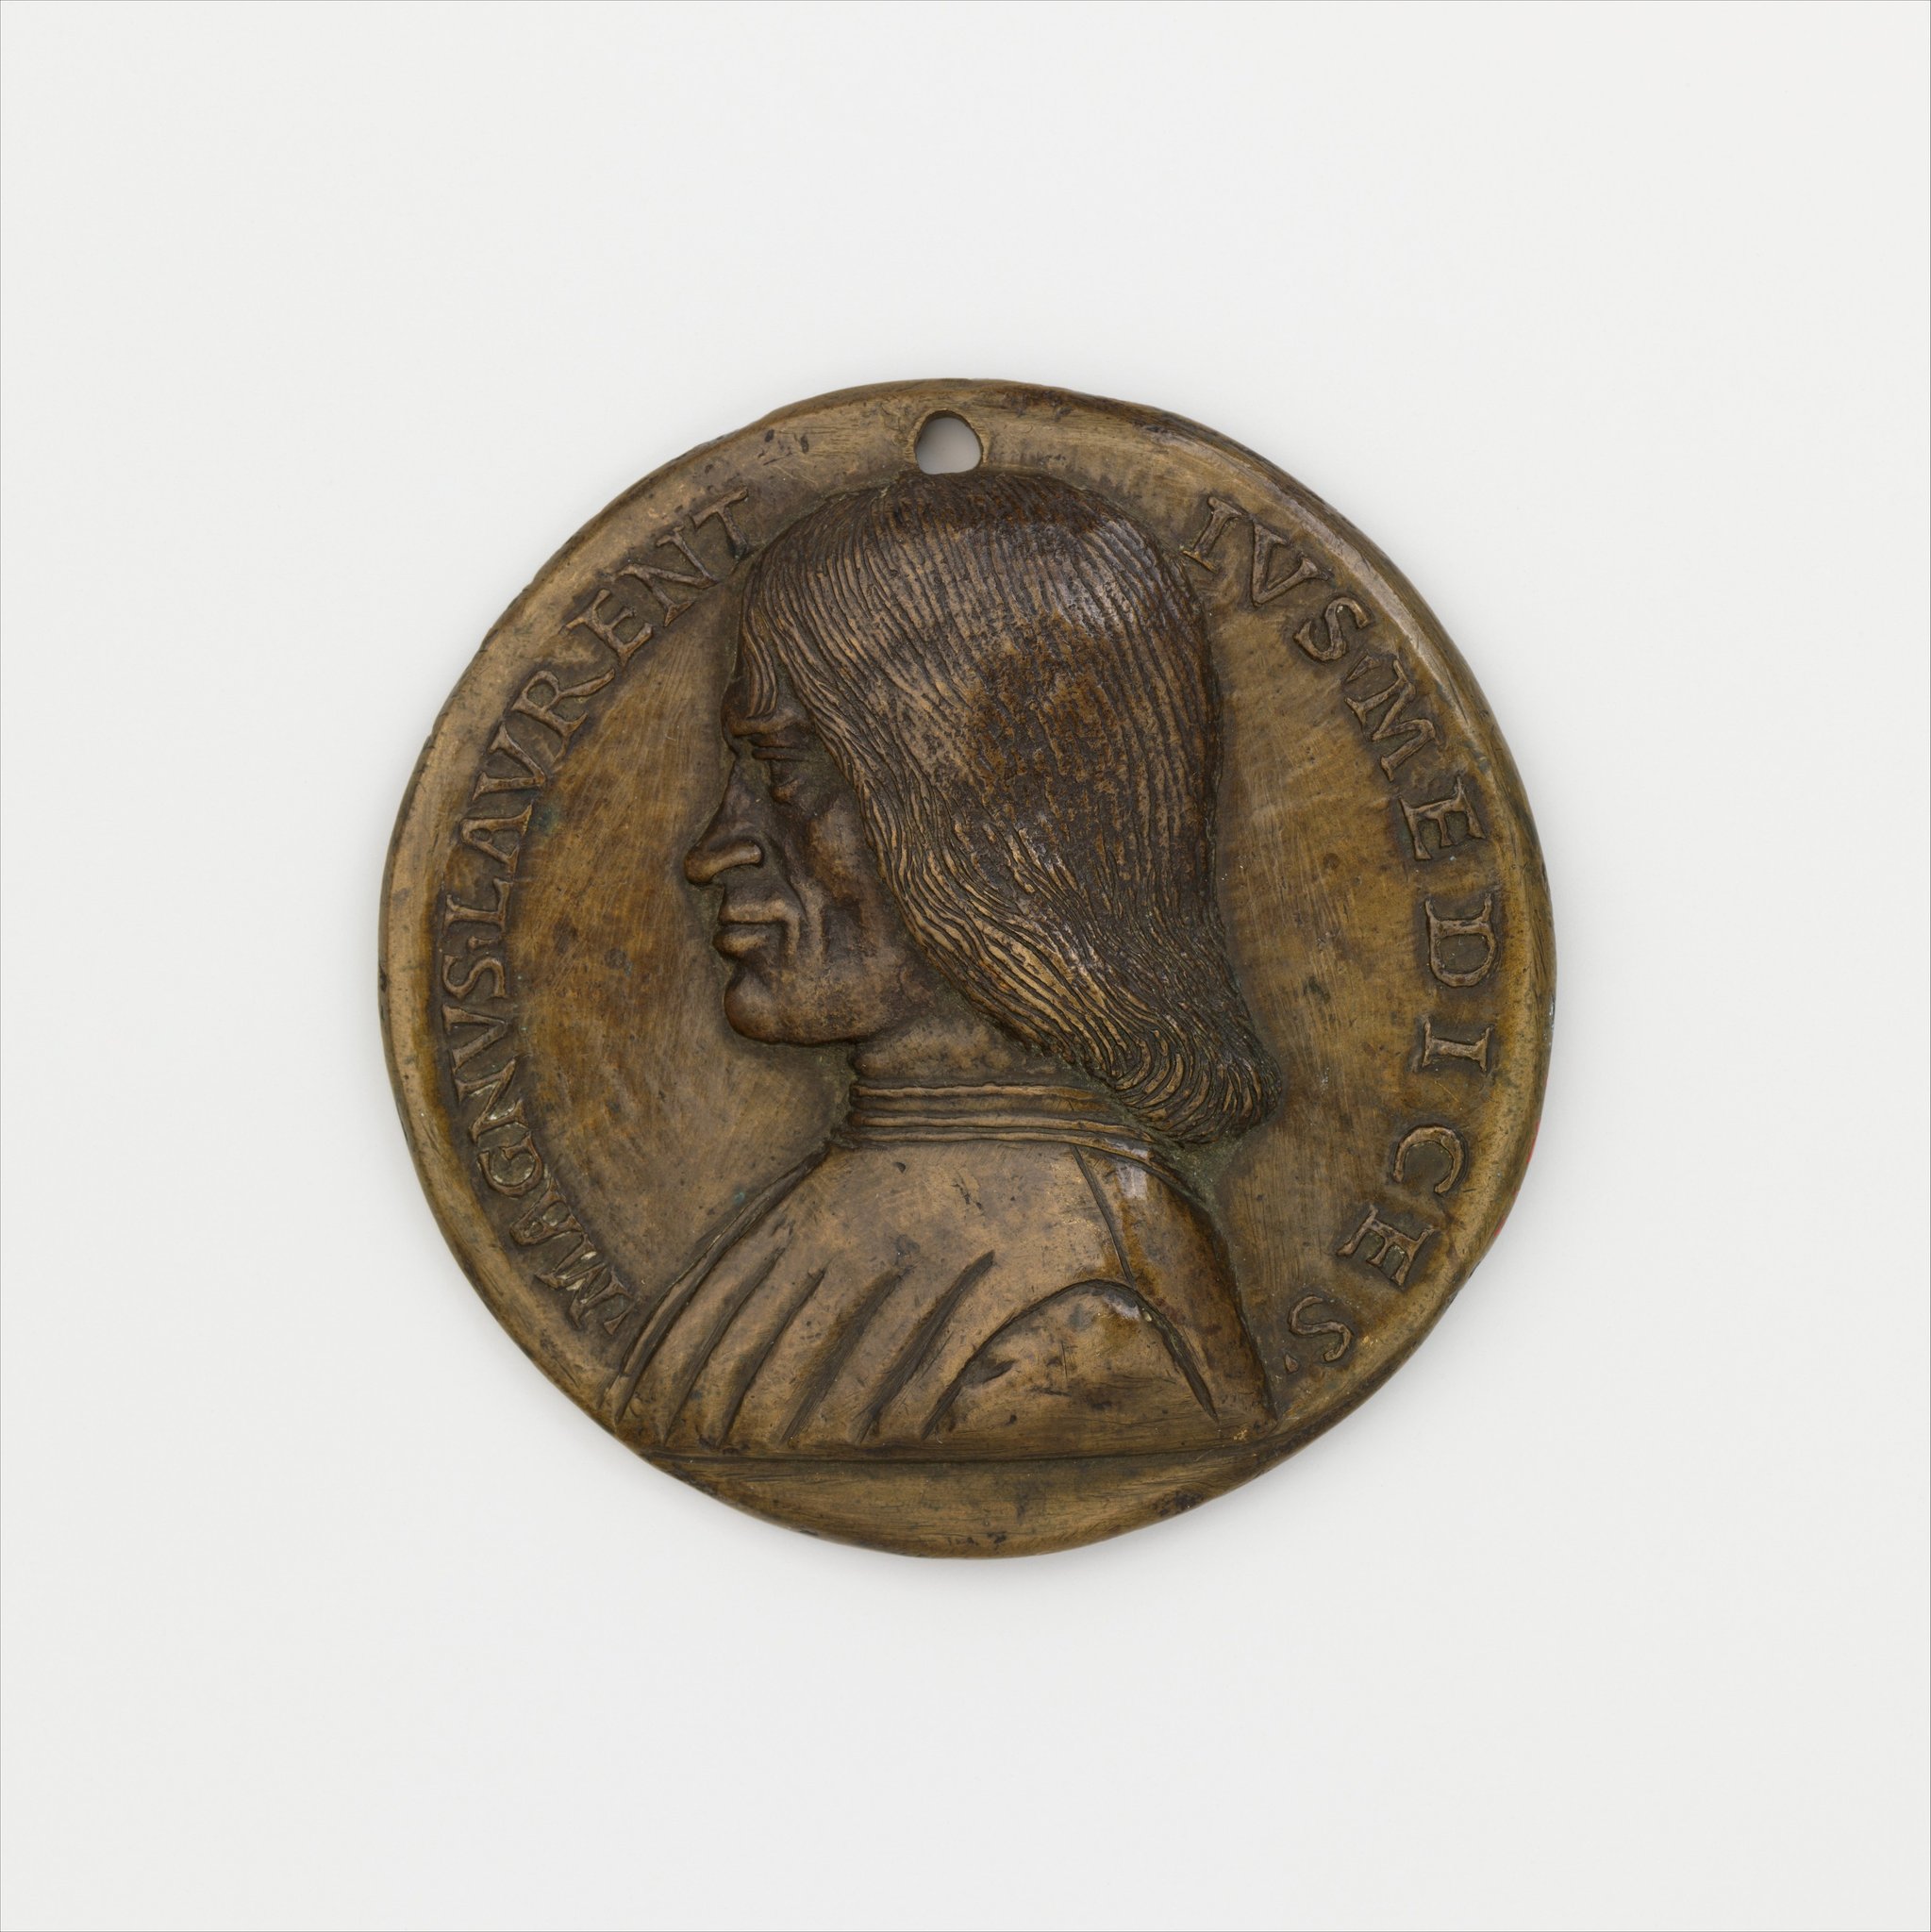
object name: medal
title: Lorenzo de' Medici, 'il Magnifico' (1448–1492)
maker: niccolò fiorentino (niccolò di forzore spinelli)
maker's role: maker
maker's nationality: italian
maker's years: 1430-1514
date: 1490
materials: bronze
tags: men,profiles